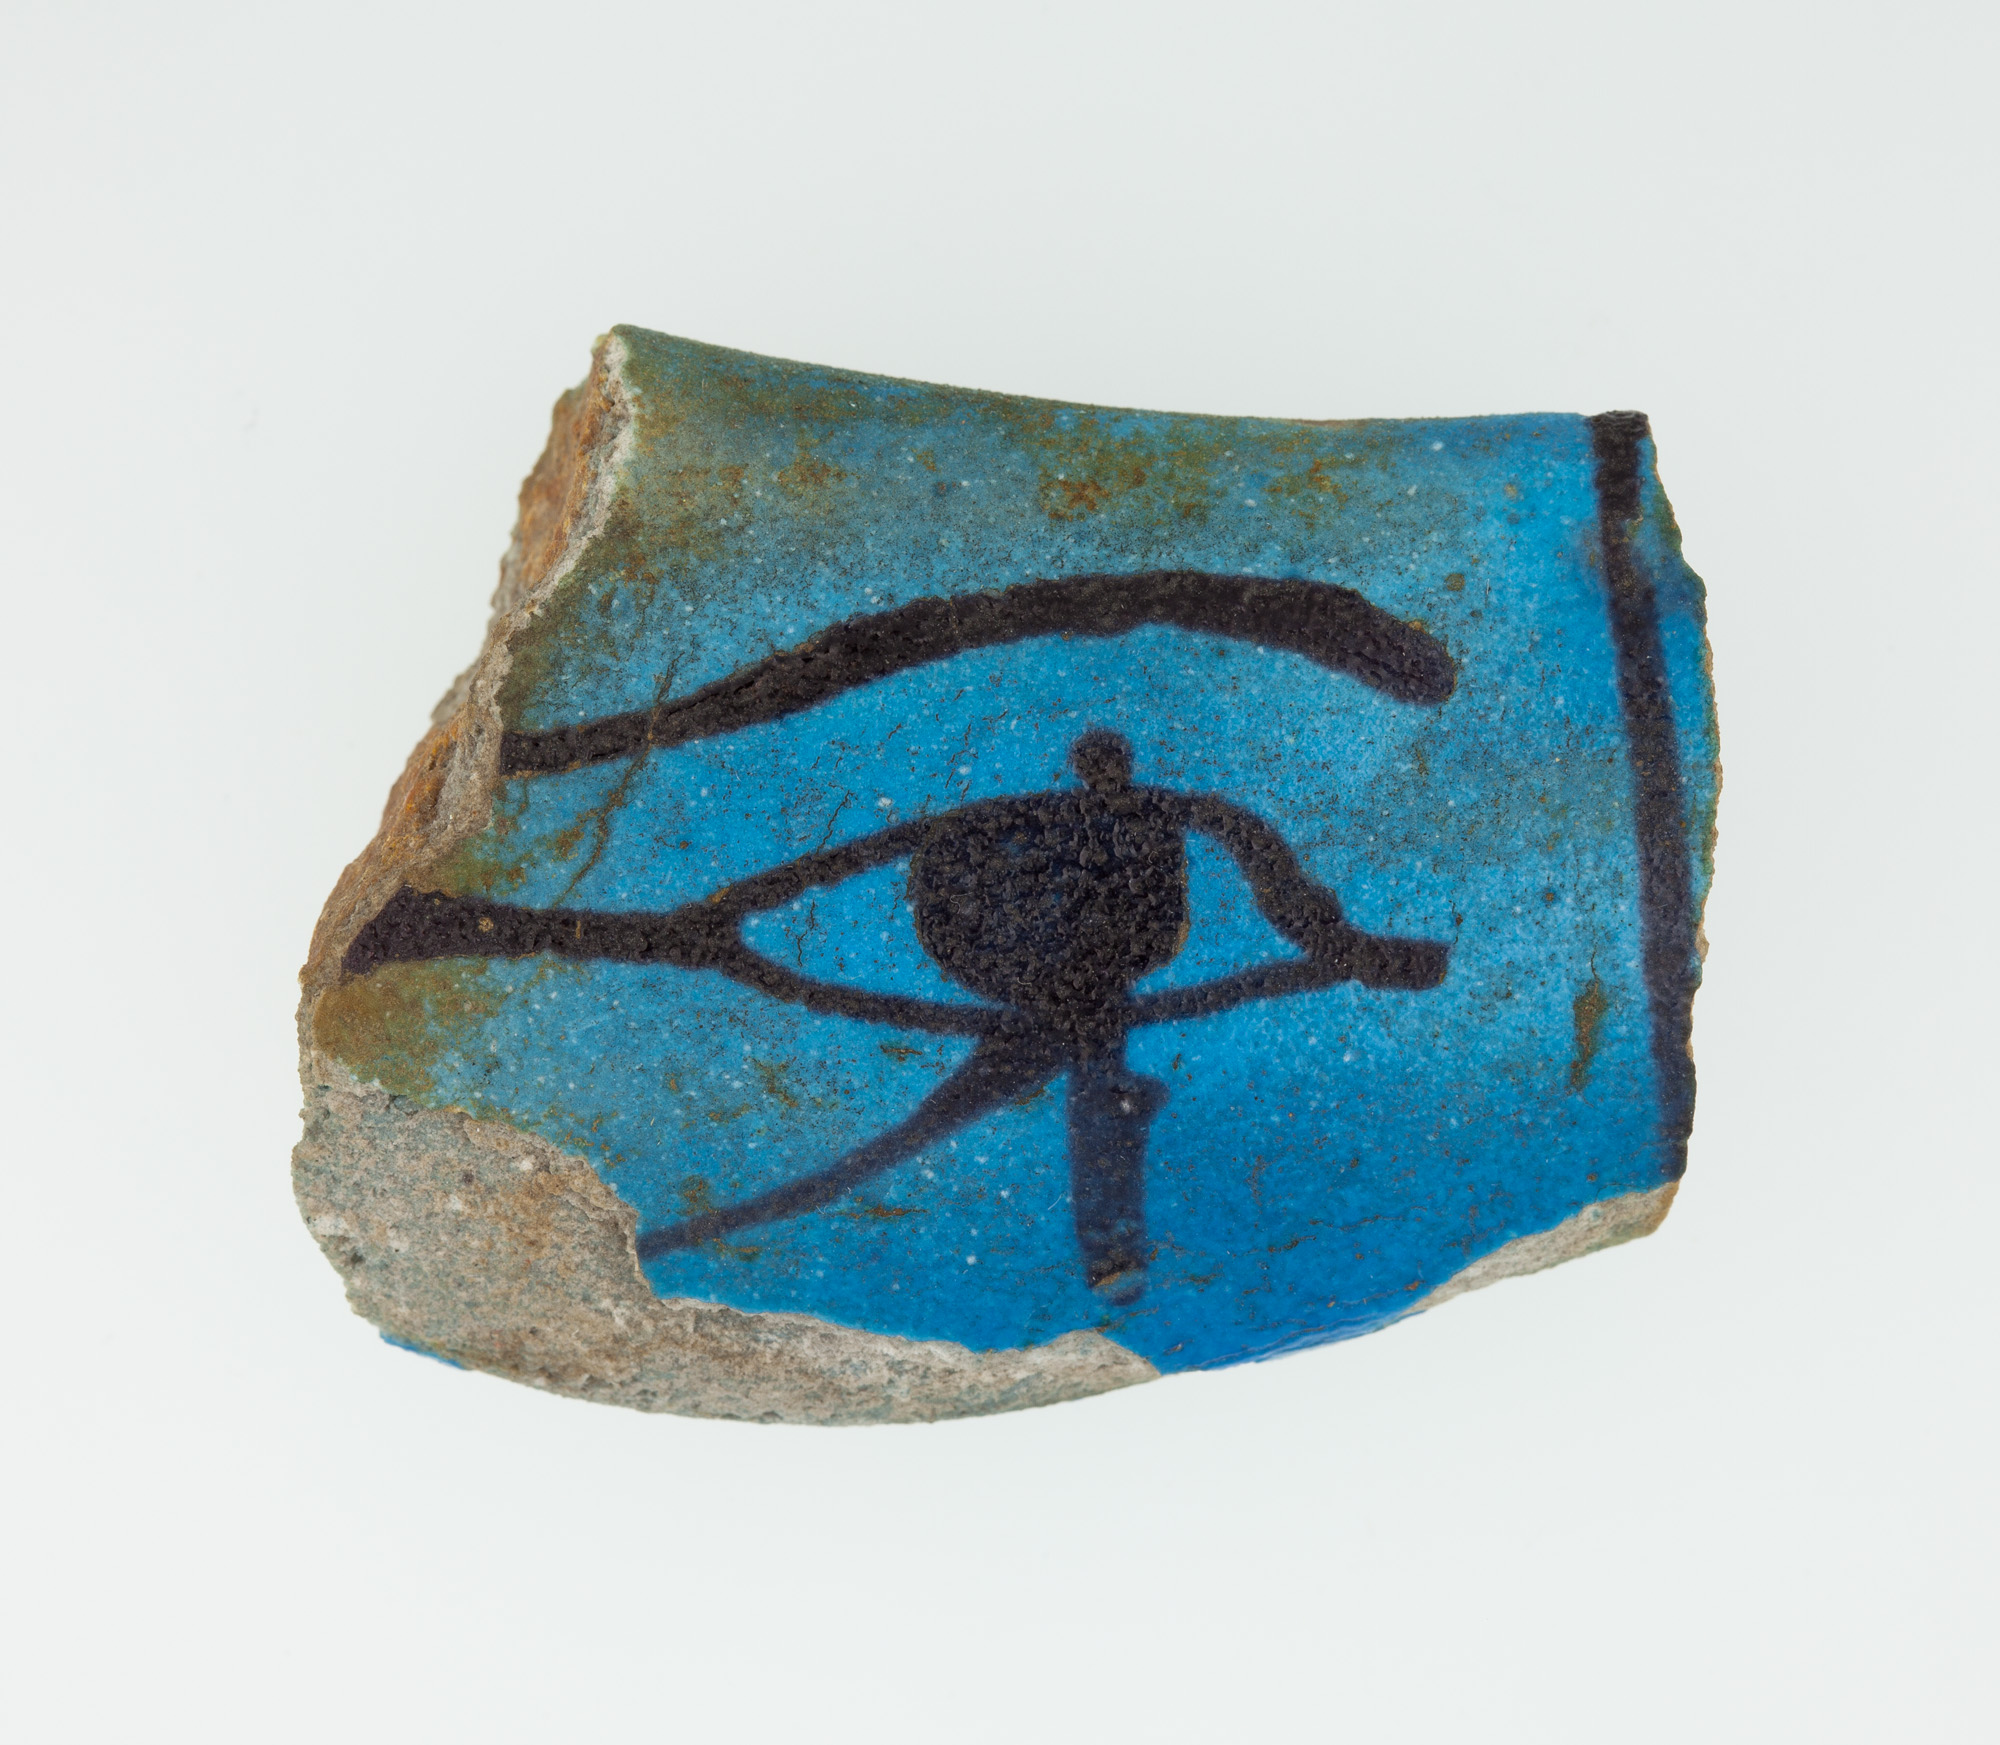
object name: model throw stick fragment, eye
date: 1479-1458 BCE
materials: faience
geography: egypt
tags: eyes